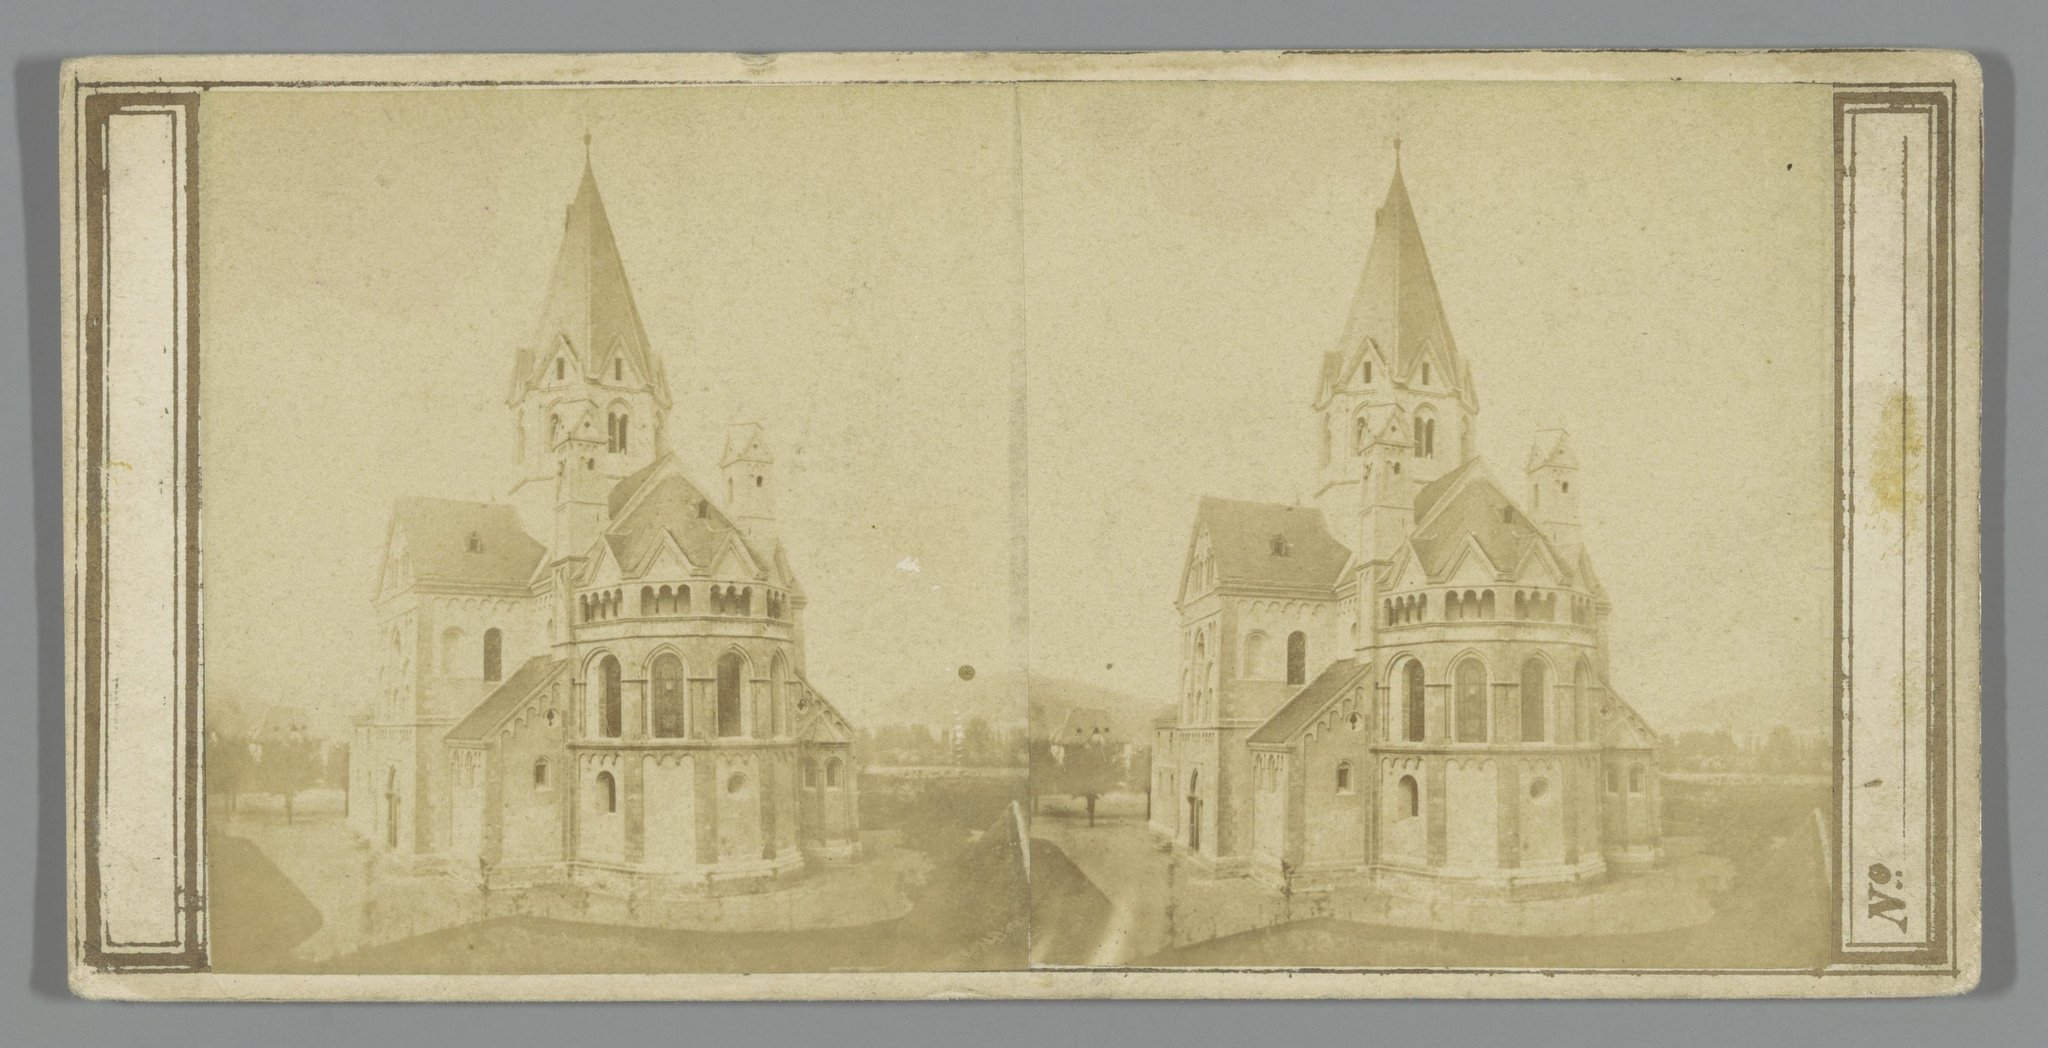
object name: stereograph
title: Kirche zu Sinzig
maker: Anonymous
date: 1860-1880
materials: cardboard, photographic support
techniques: albumen print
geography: sinzig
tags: façade (of house or building)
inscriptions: number: ‘Nro. 89.’